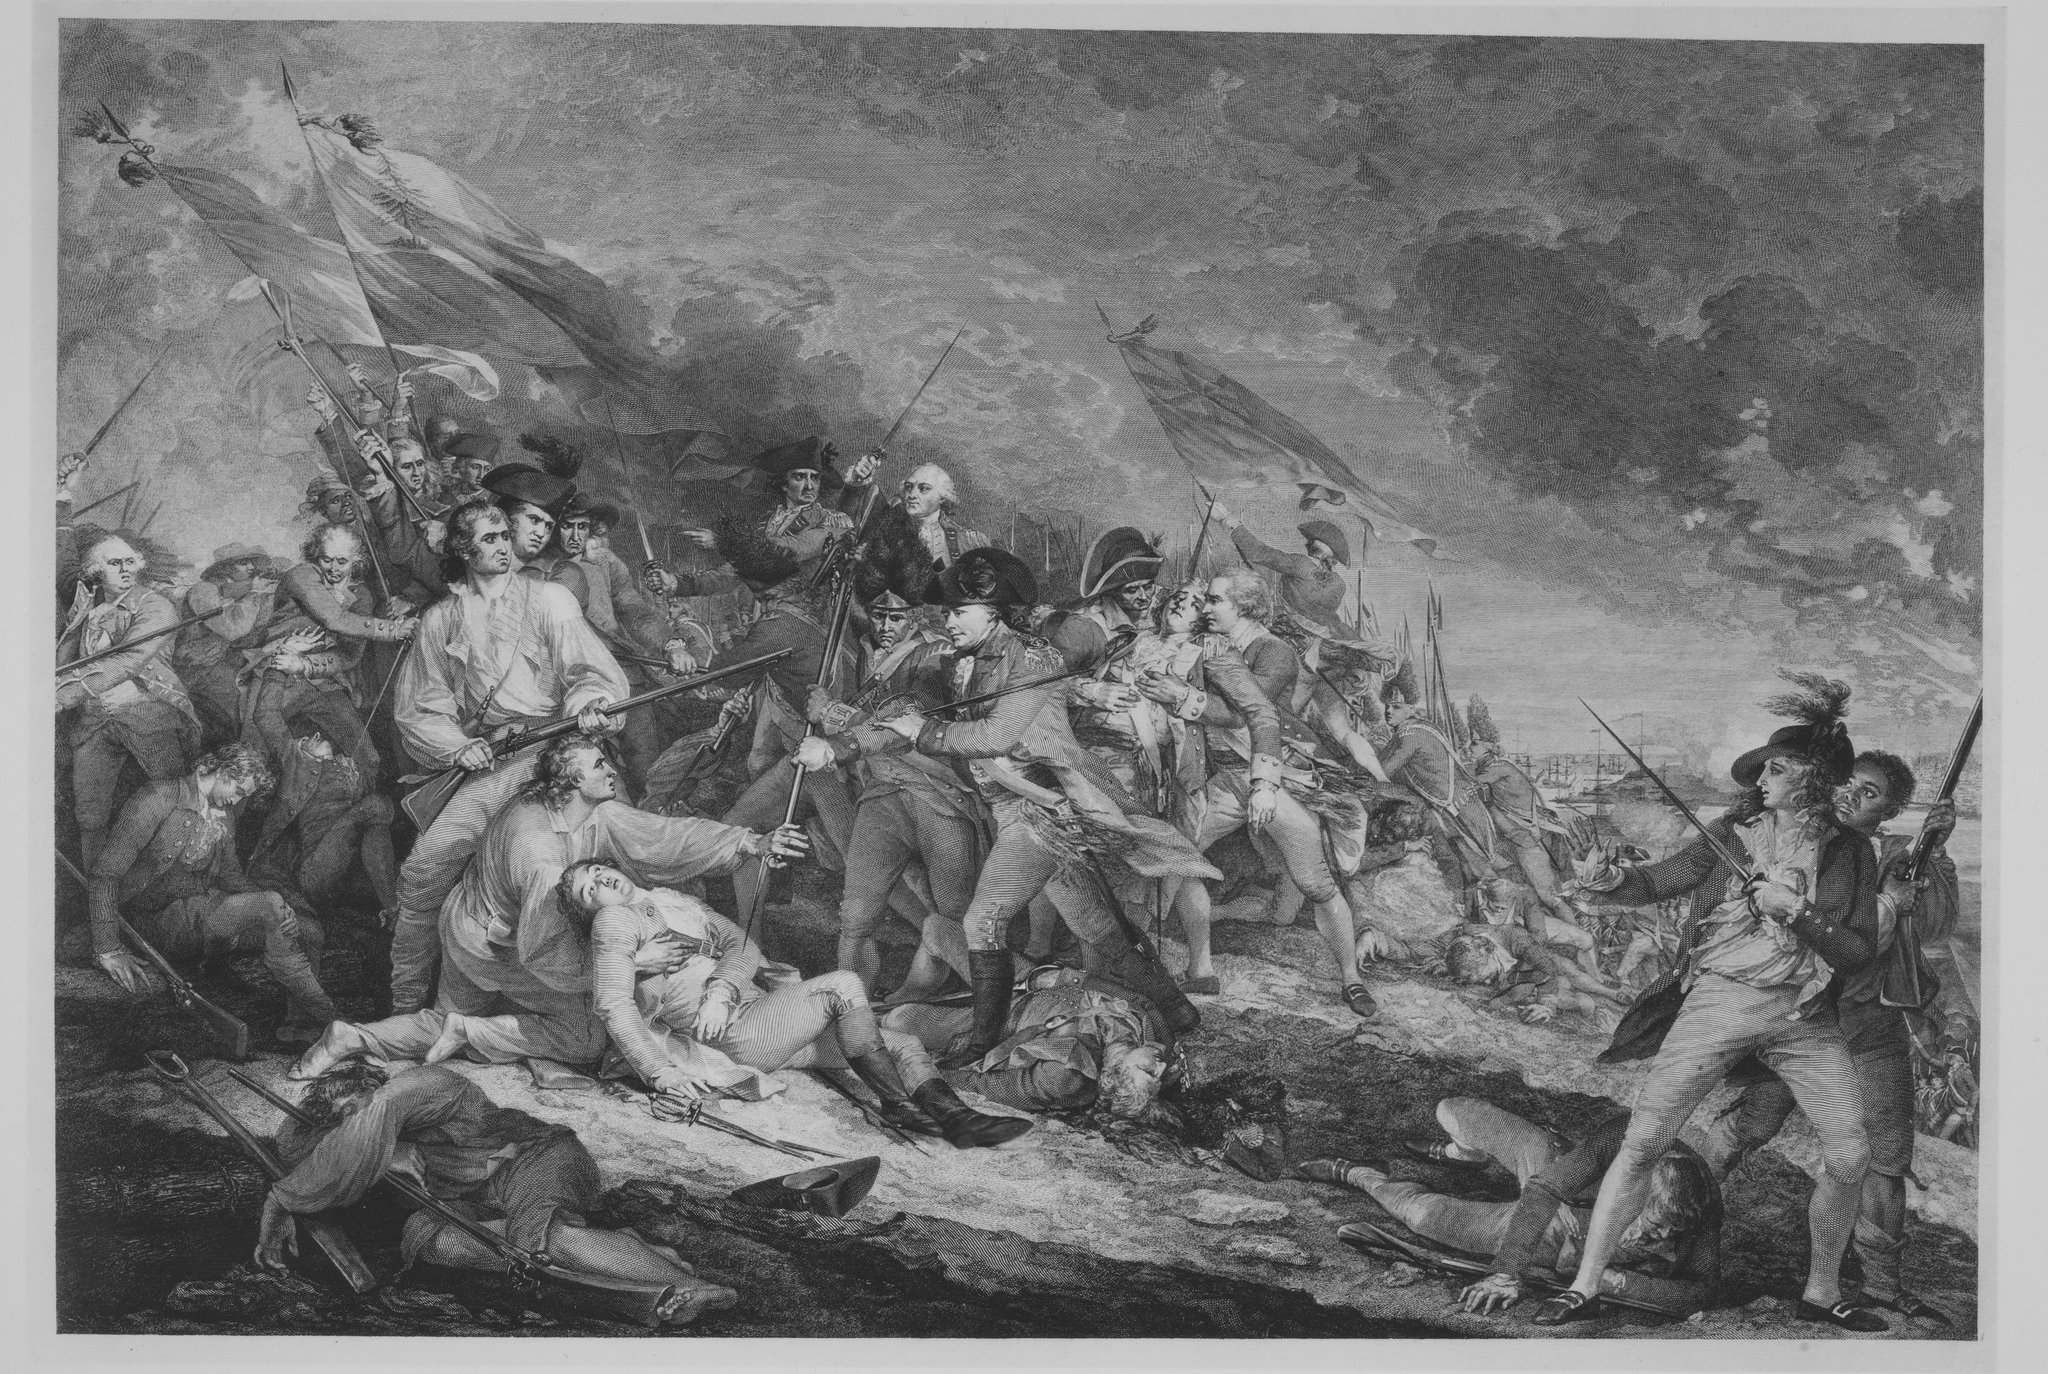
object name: print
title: The Battle of Bunker's Hill (June 17, 1775)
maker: johann gotthard müller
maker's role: engraver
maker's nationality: german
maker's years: 1747-1830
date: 1788-1798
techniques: engraving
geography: england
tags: battles,soldiers,firearms,american revolution,flags